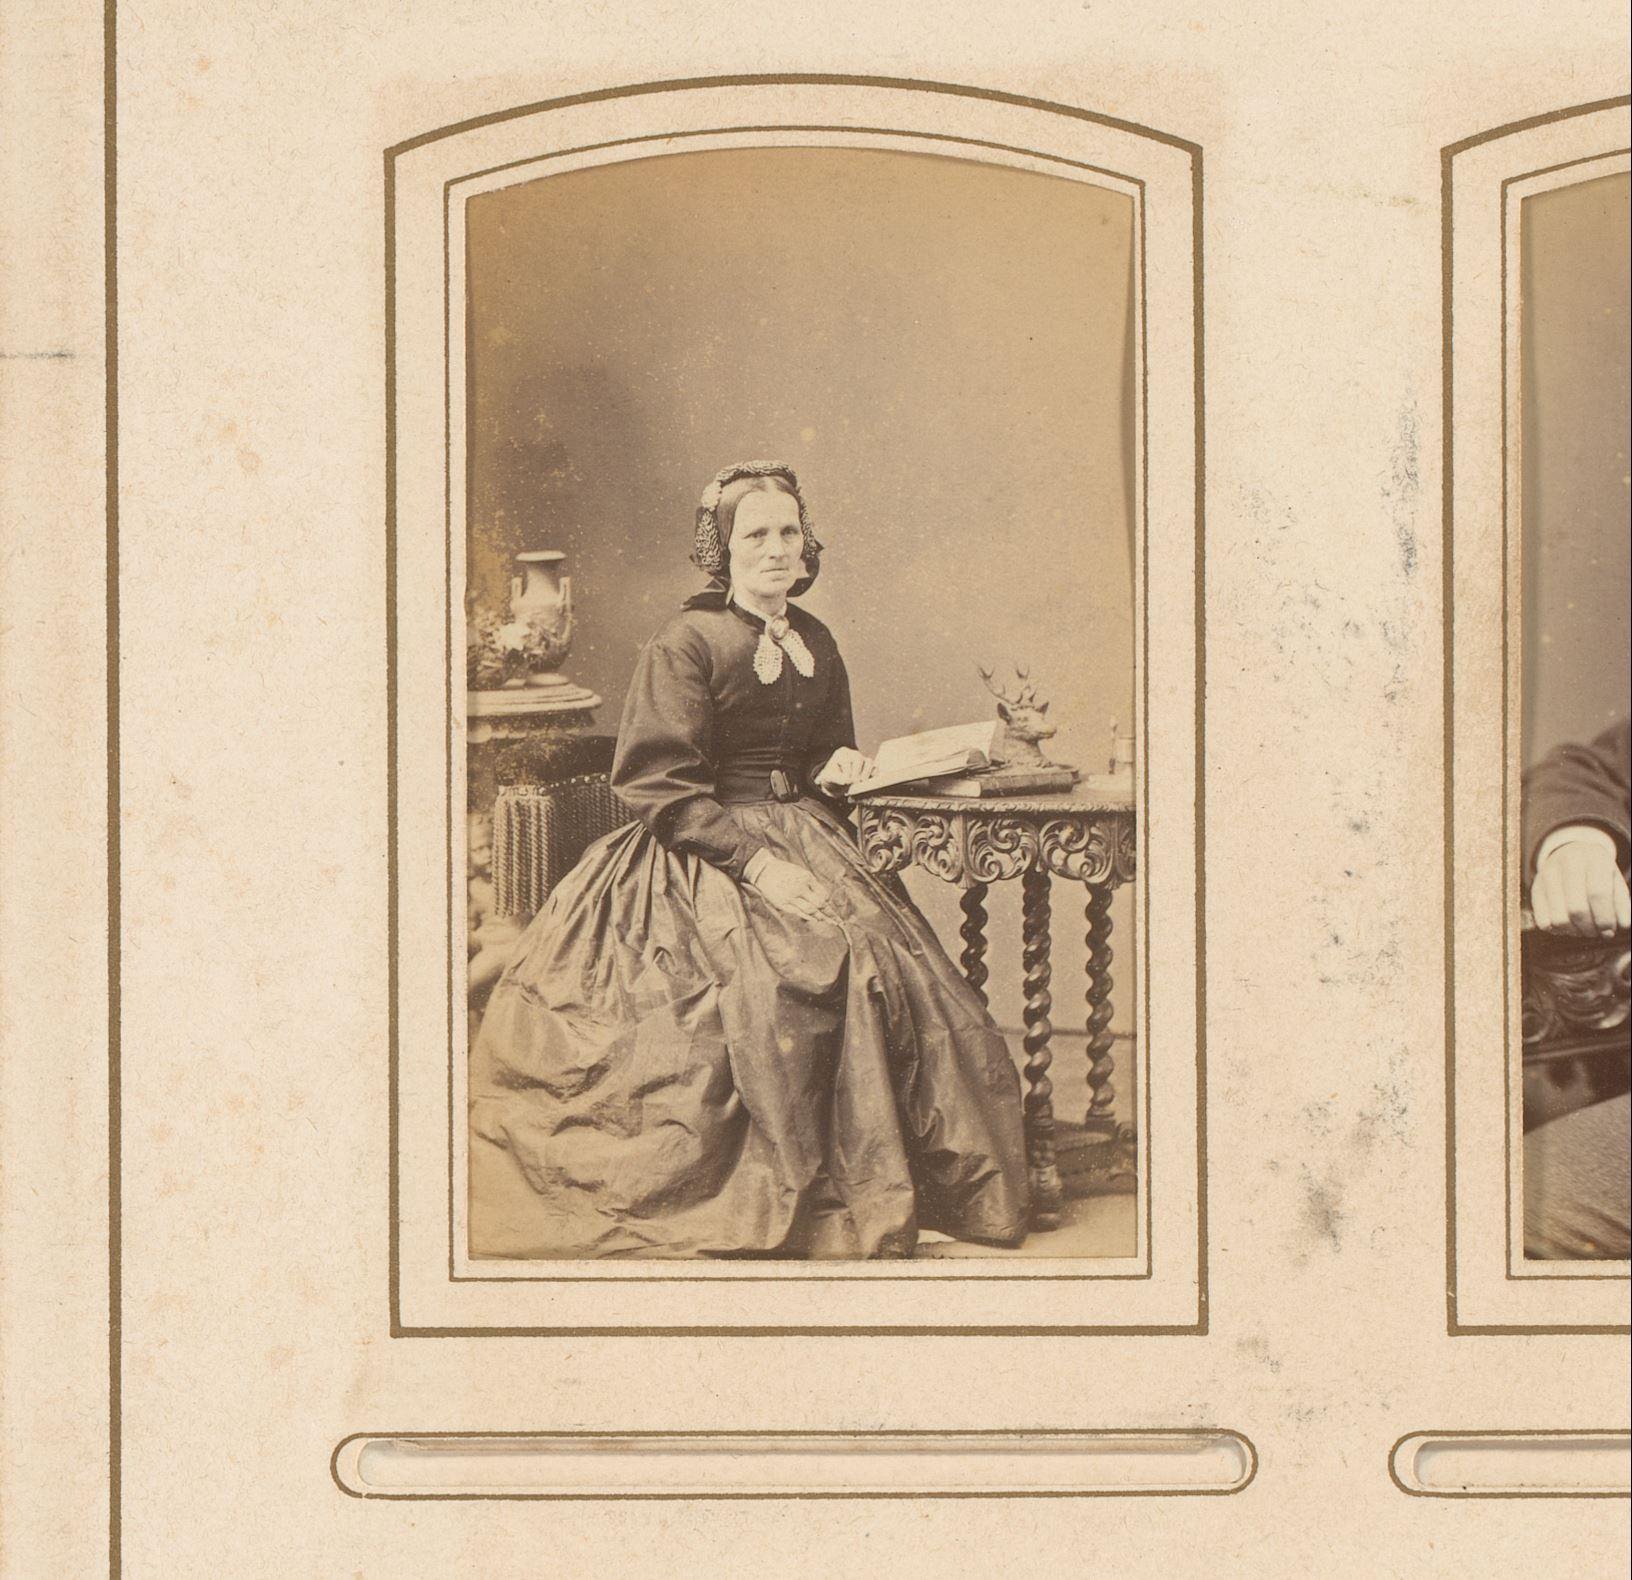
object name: photograph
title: Portret van een zittende vrouw met een boek op tafel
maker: john hawke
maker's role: fotograaf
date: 1866-1893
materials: cardboard, paper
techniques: albumen print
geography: plymouth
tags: sitting figure, historical persons - bb - woman, book - mm - book open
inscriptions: inscription: ‘LIGHT AND TRUTH/ J N O HAWKE/ 8, George Street/ PLYMOUTH’